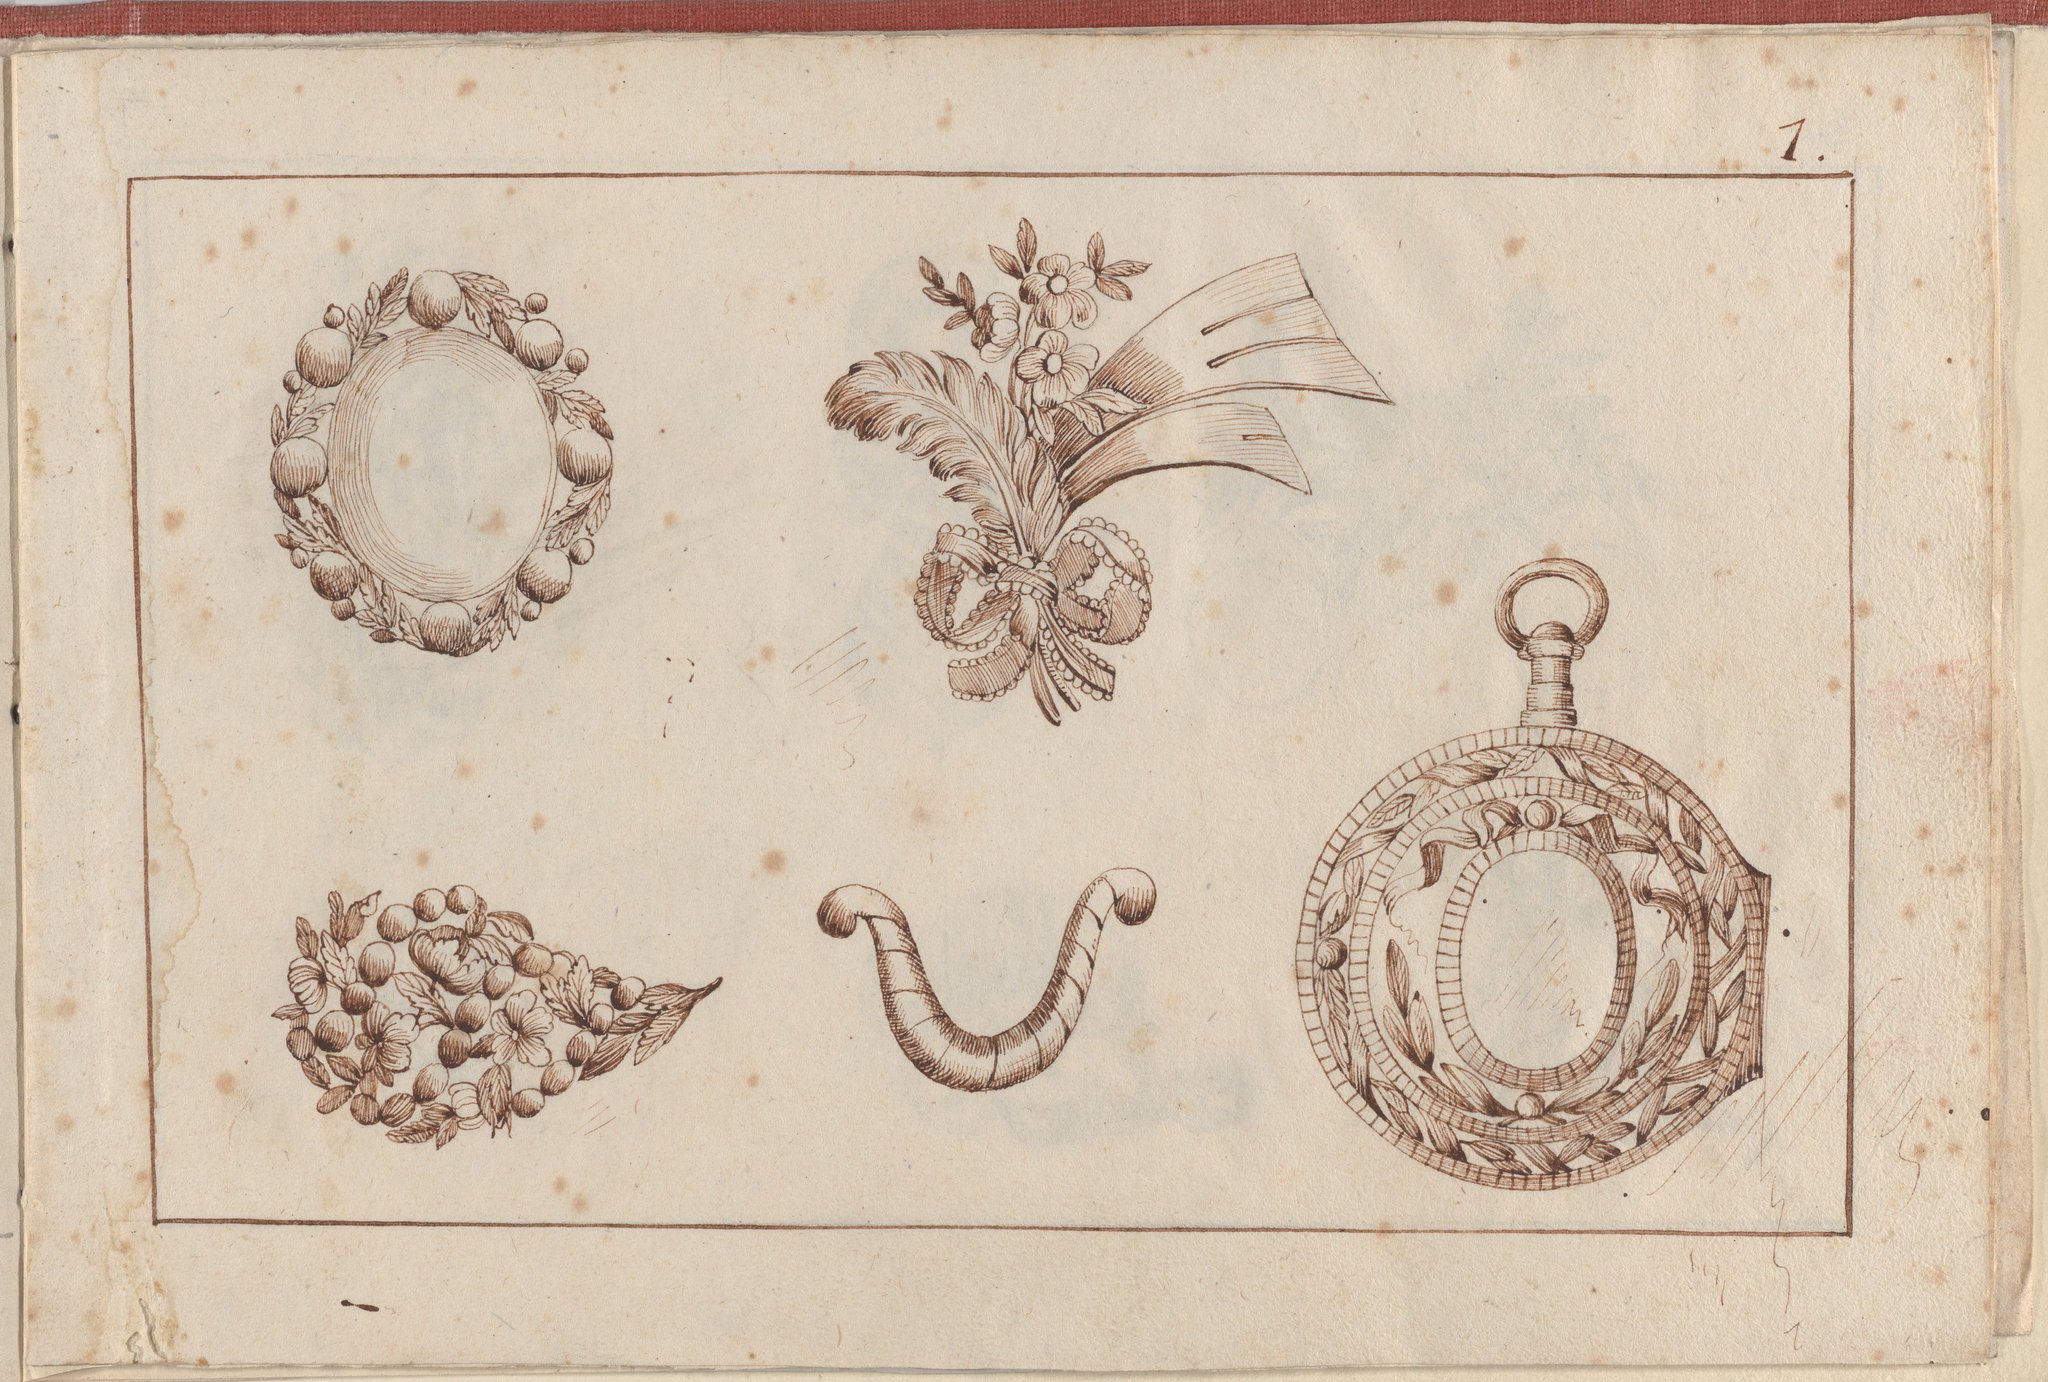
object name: album print ornament architecture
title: Joaillerie: Album of Jewelry Designs, Page 1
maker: anonymous, french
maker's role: artist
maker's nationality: french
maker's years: 1400-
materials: ink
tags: jewelry